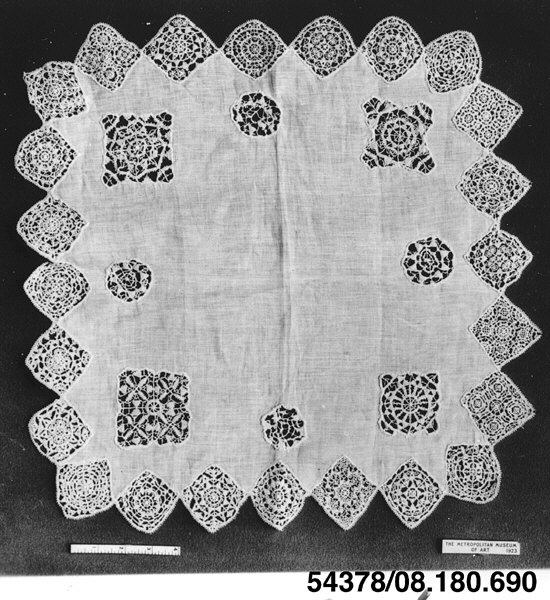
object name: handkerchief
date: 1601-1700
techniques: lace